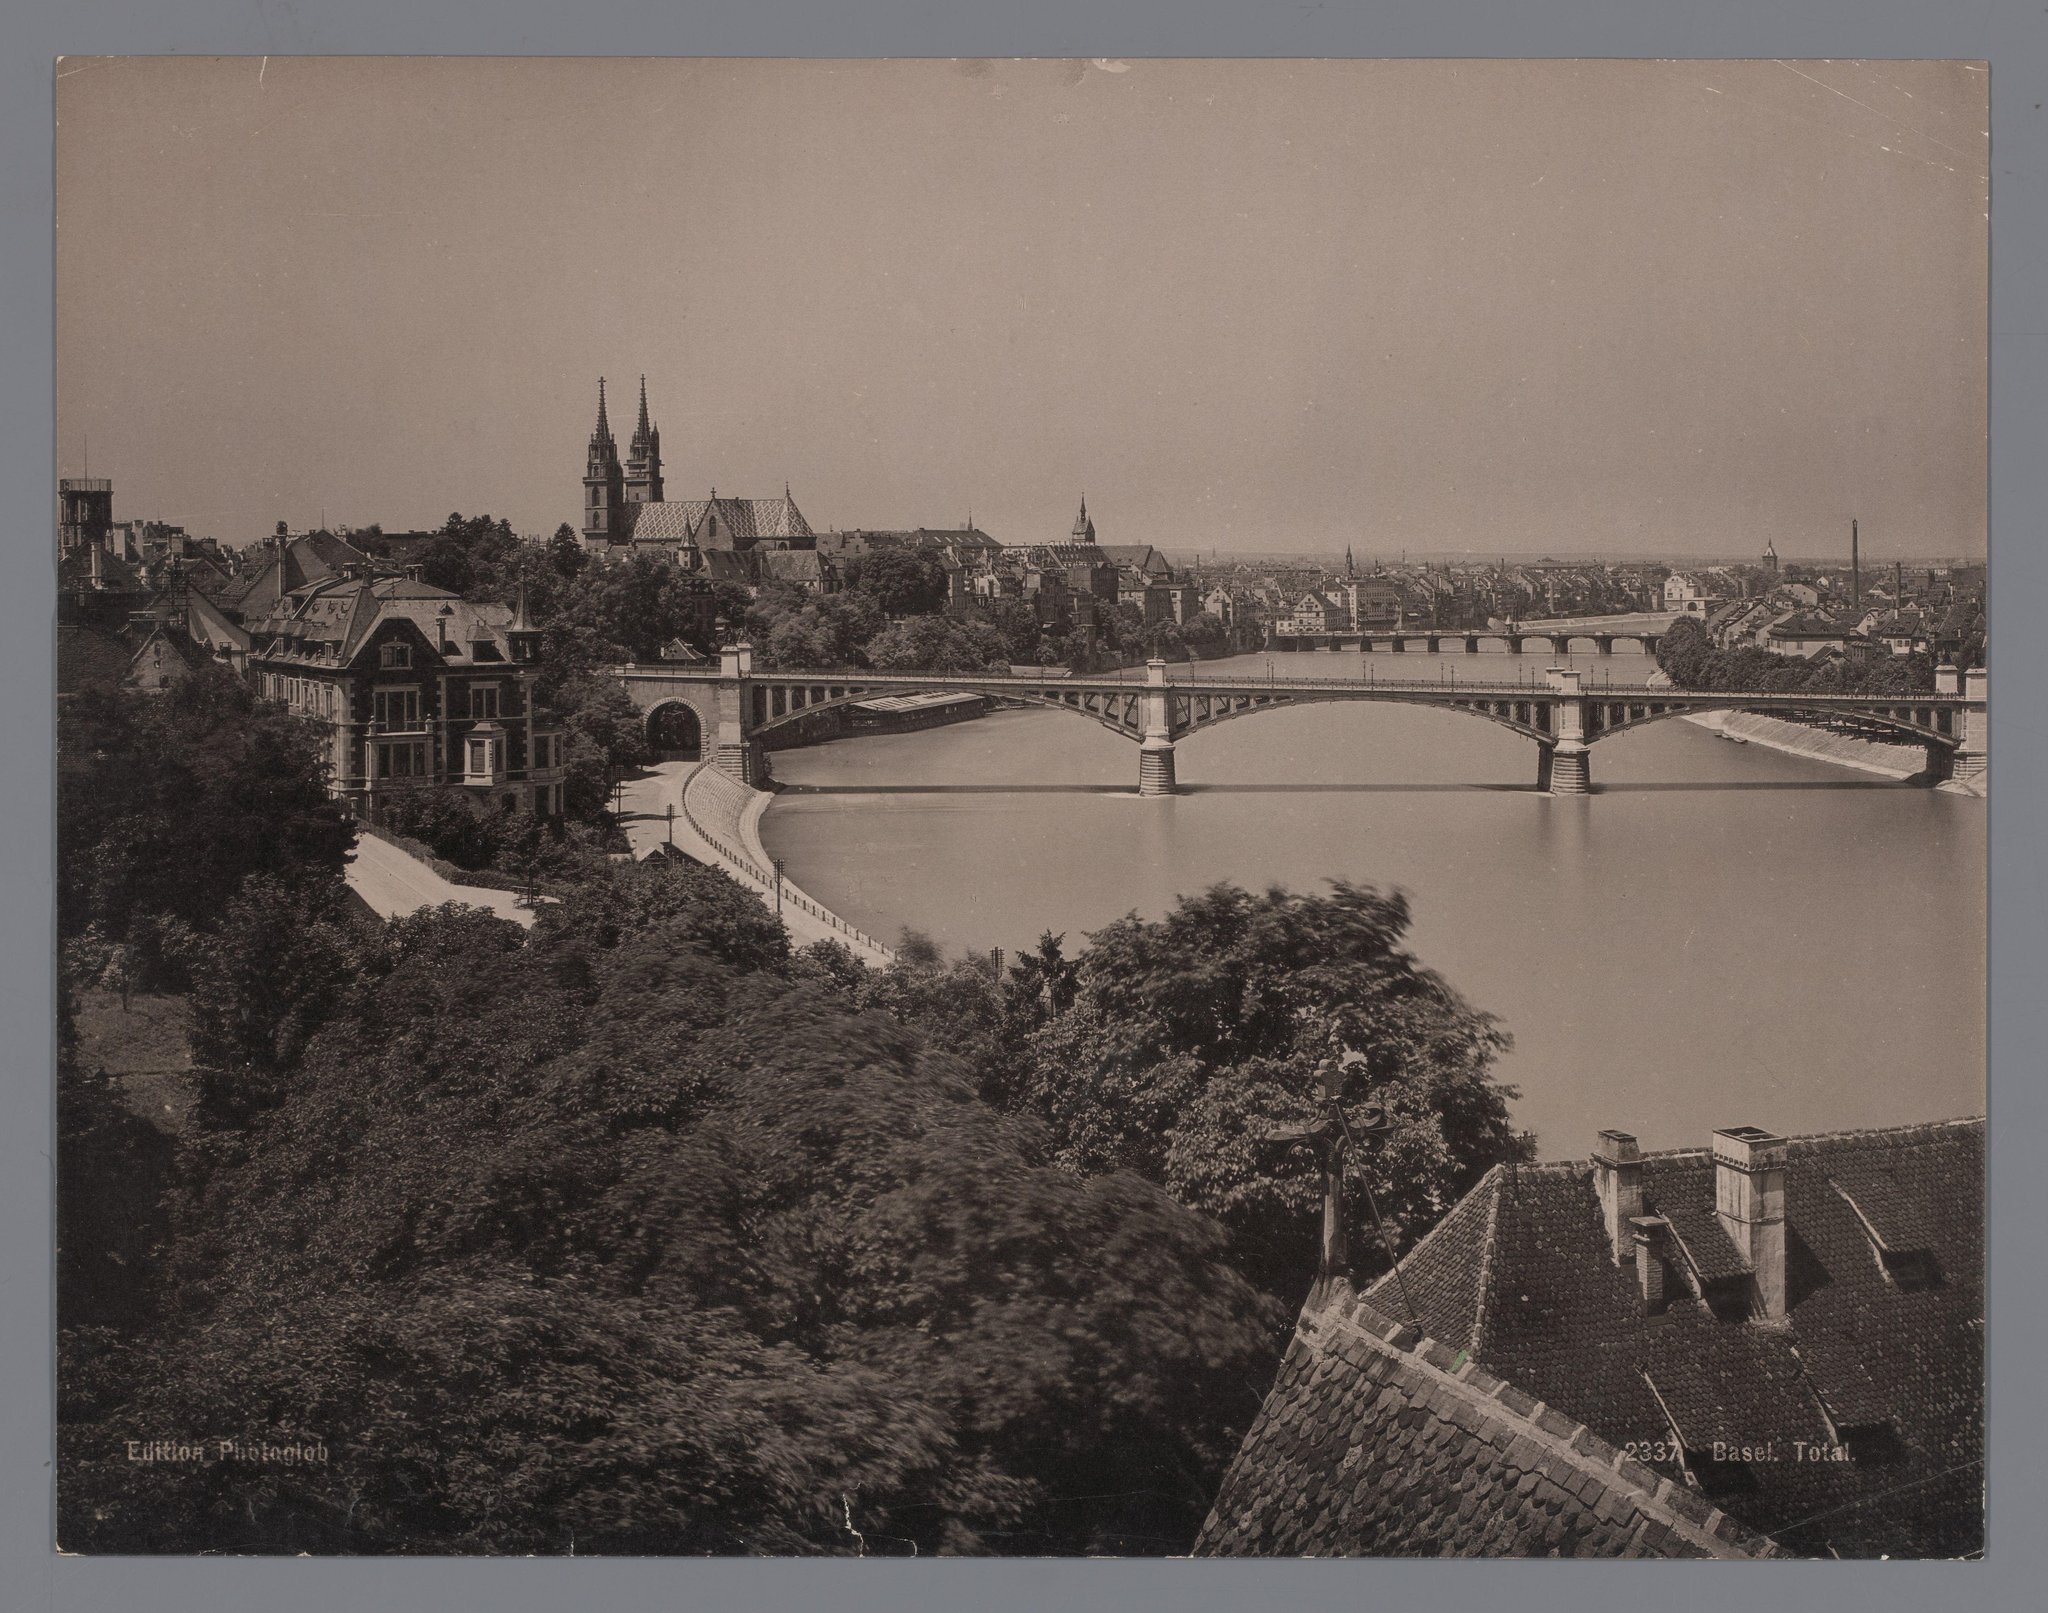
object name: photograph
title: Basel, Zwitserland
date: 1890-1925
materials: paper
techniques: collodion silver print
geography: switzerland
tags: bazel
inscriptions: inscription: ‘EditionPhotoglob’, inscription: ‘2337 Basel. Total.’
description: Gezicht met brug en kerk, bomen en de daken van de huizen onder in beeld op Bazel, gelegen aan de Rijn en de Birs.